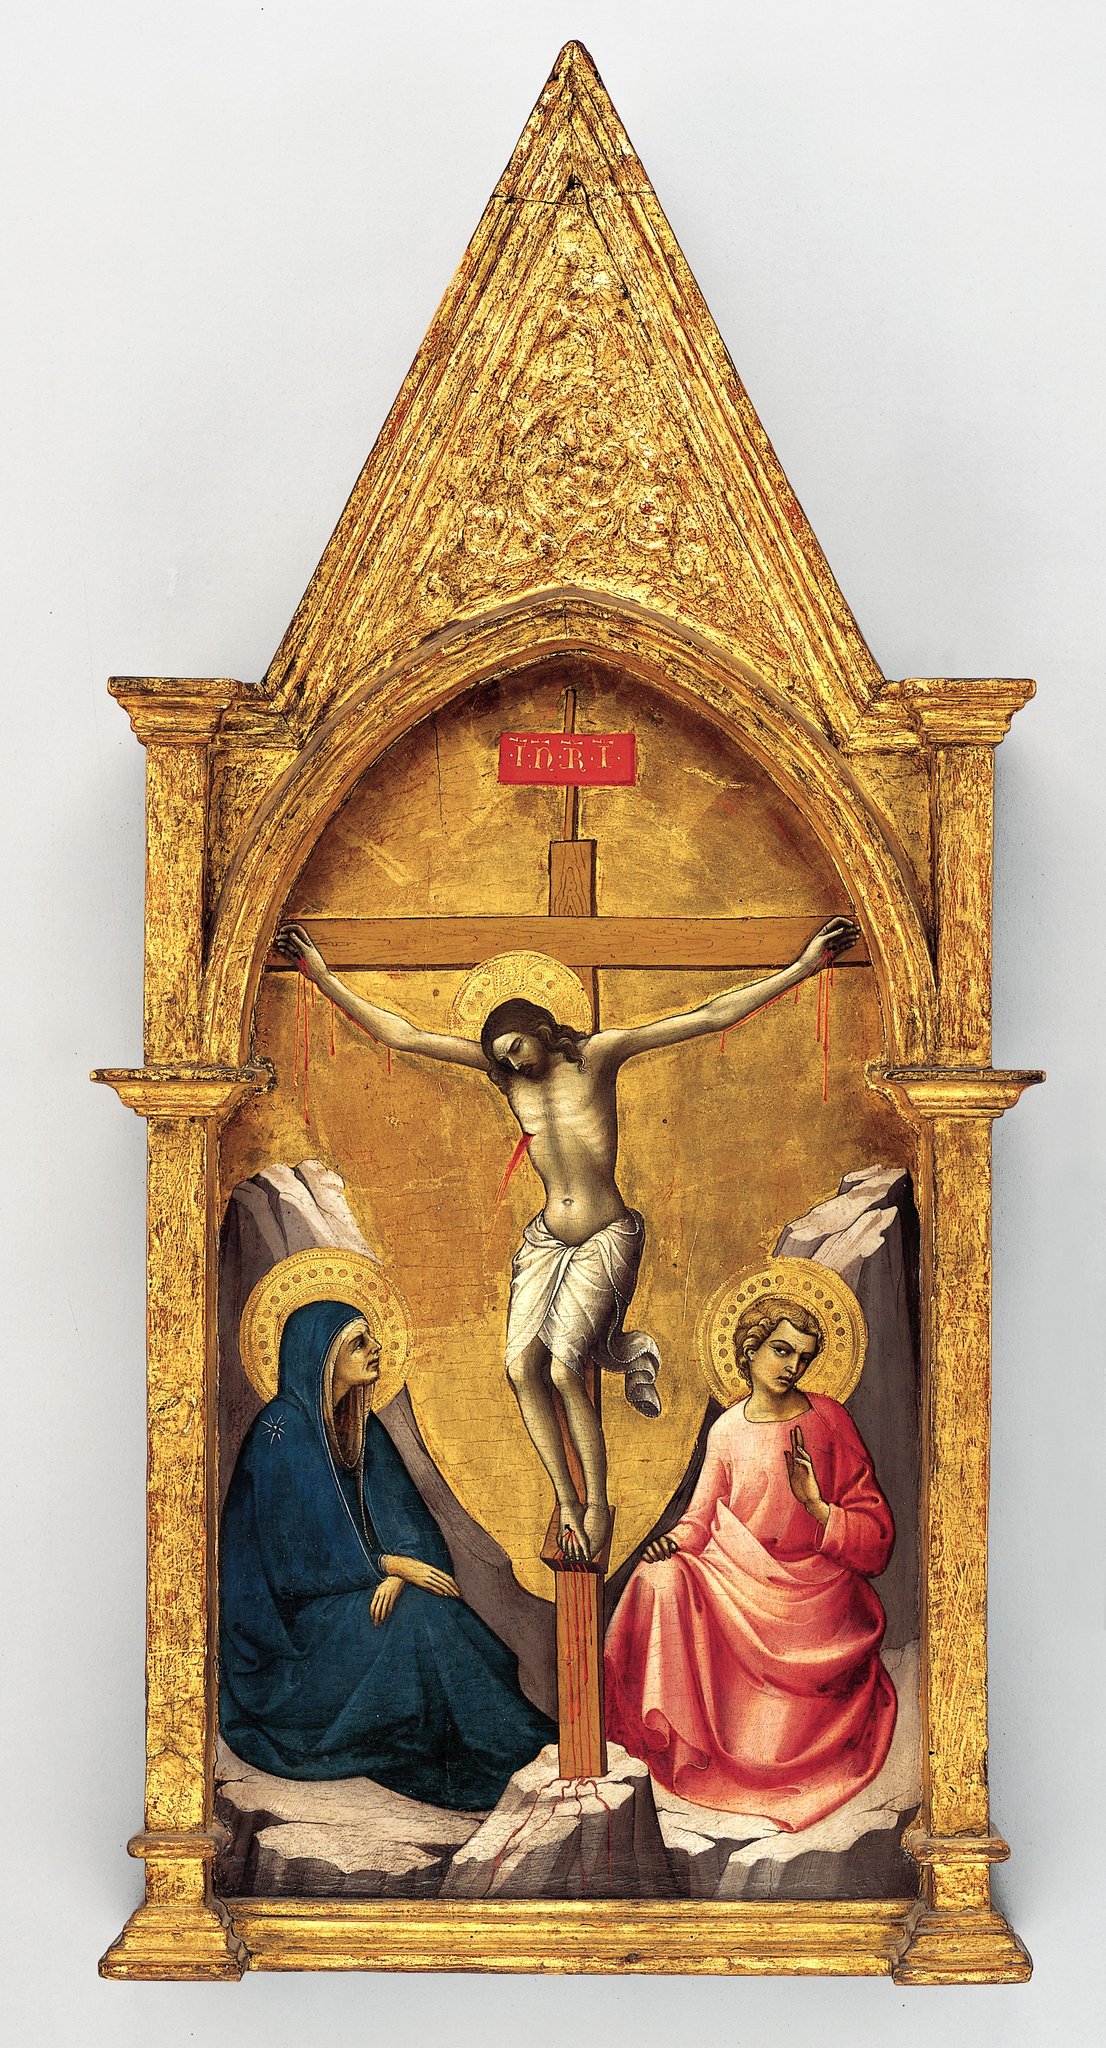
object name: frame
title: Tabernacle frame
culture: italian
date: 1404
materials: gilt, wood